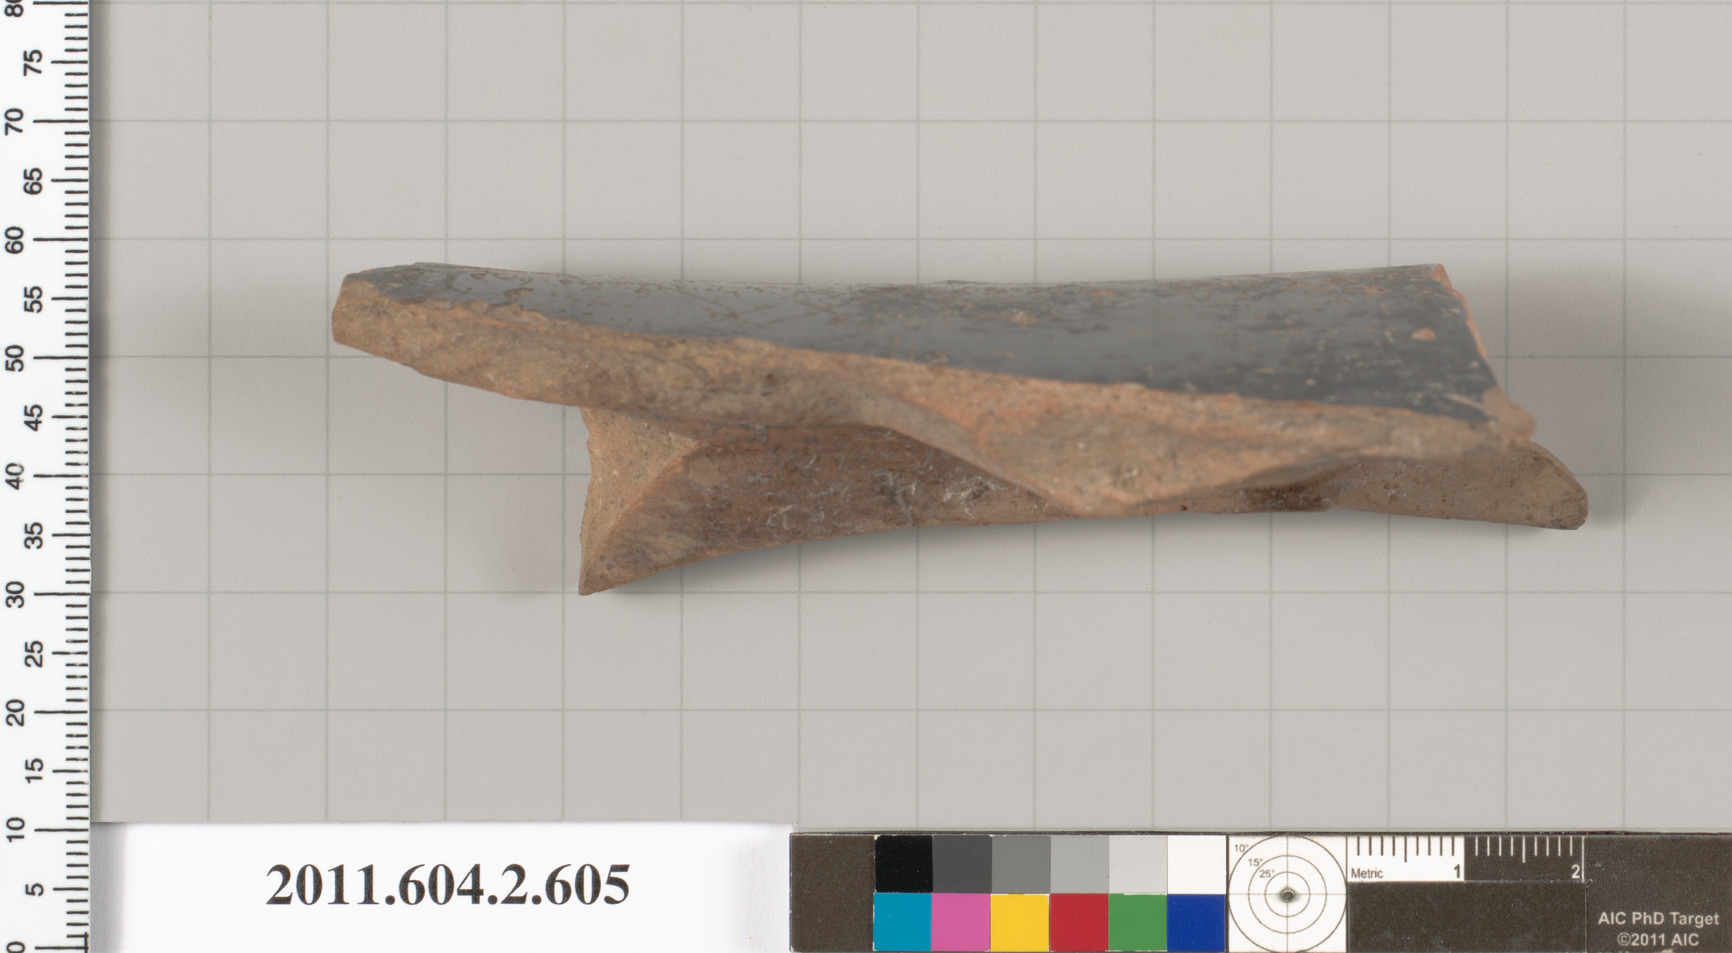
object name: column krater fragment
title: Terracotta fragment of a column-krater (bowl for mixing wine and water)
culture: greek, attic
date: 475-451 BCE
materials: terracotta